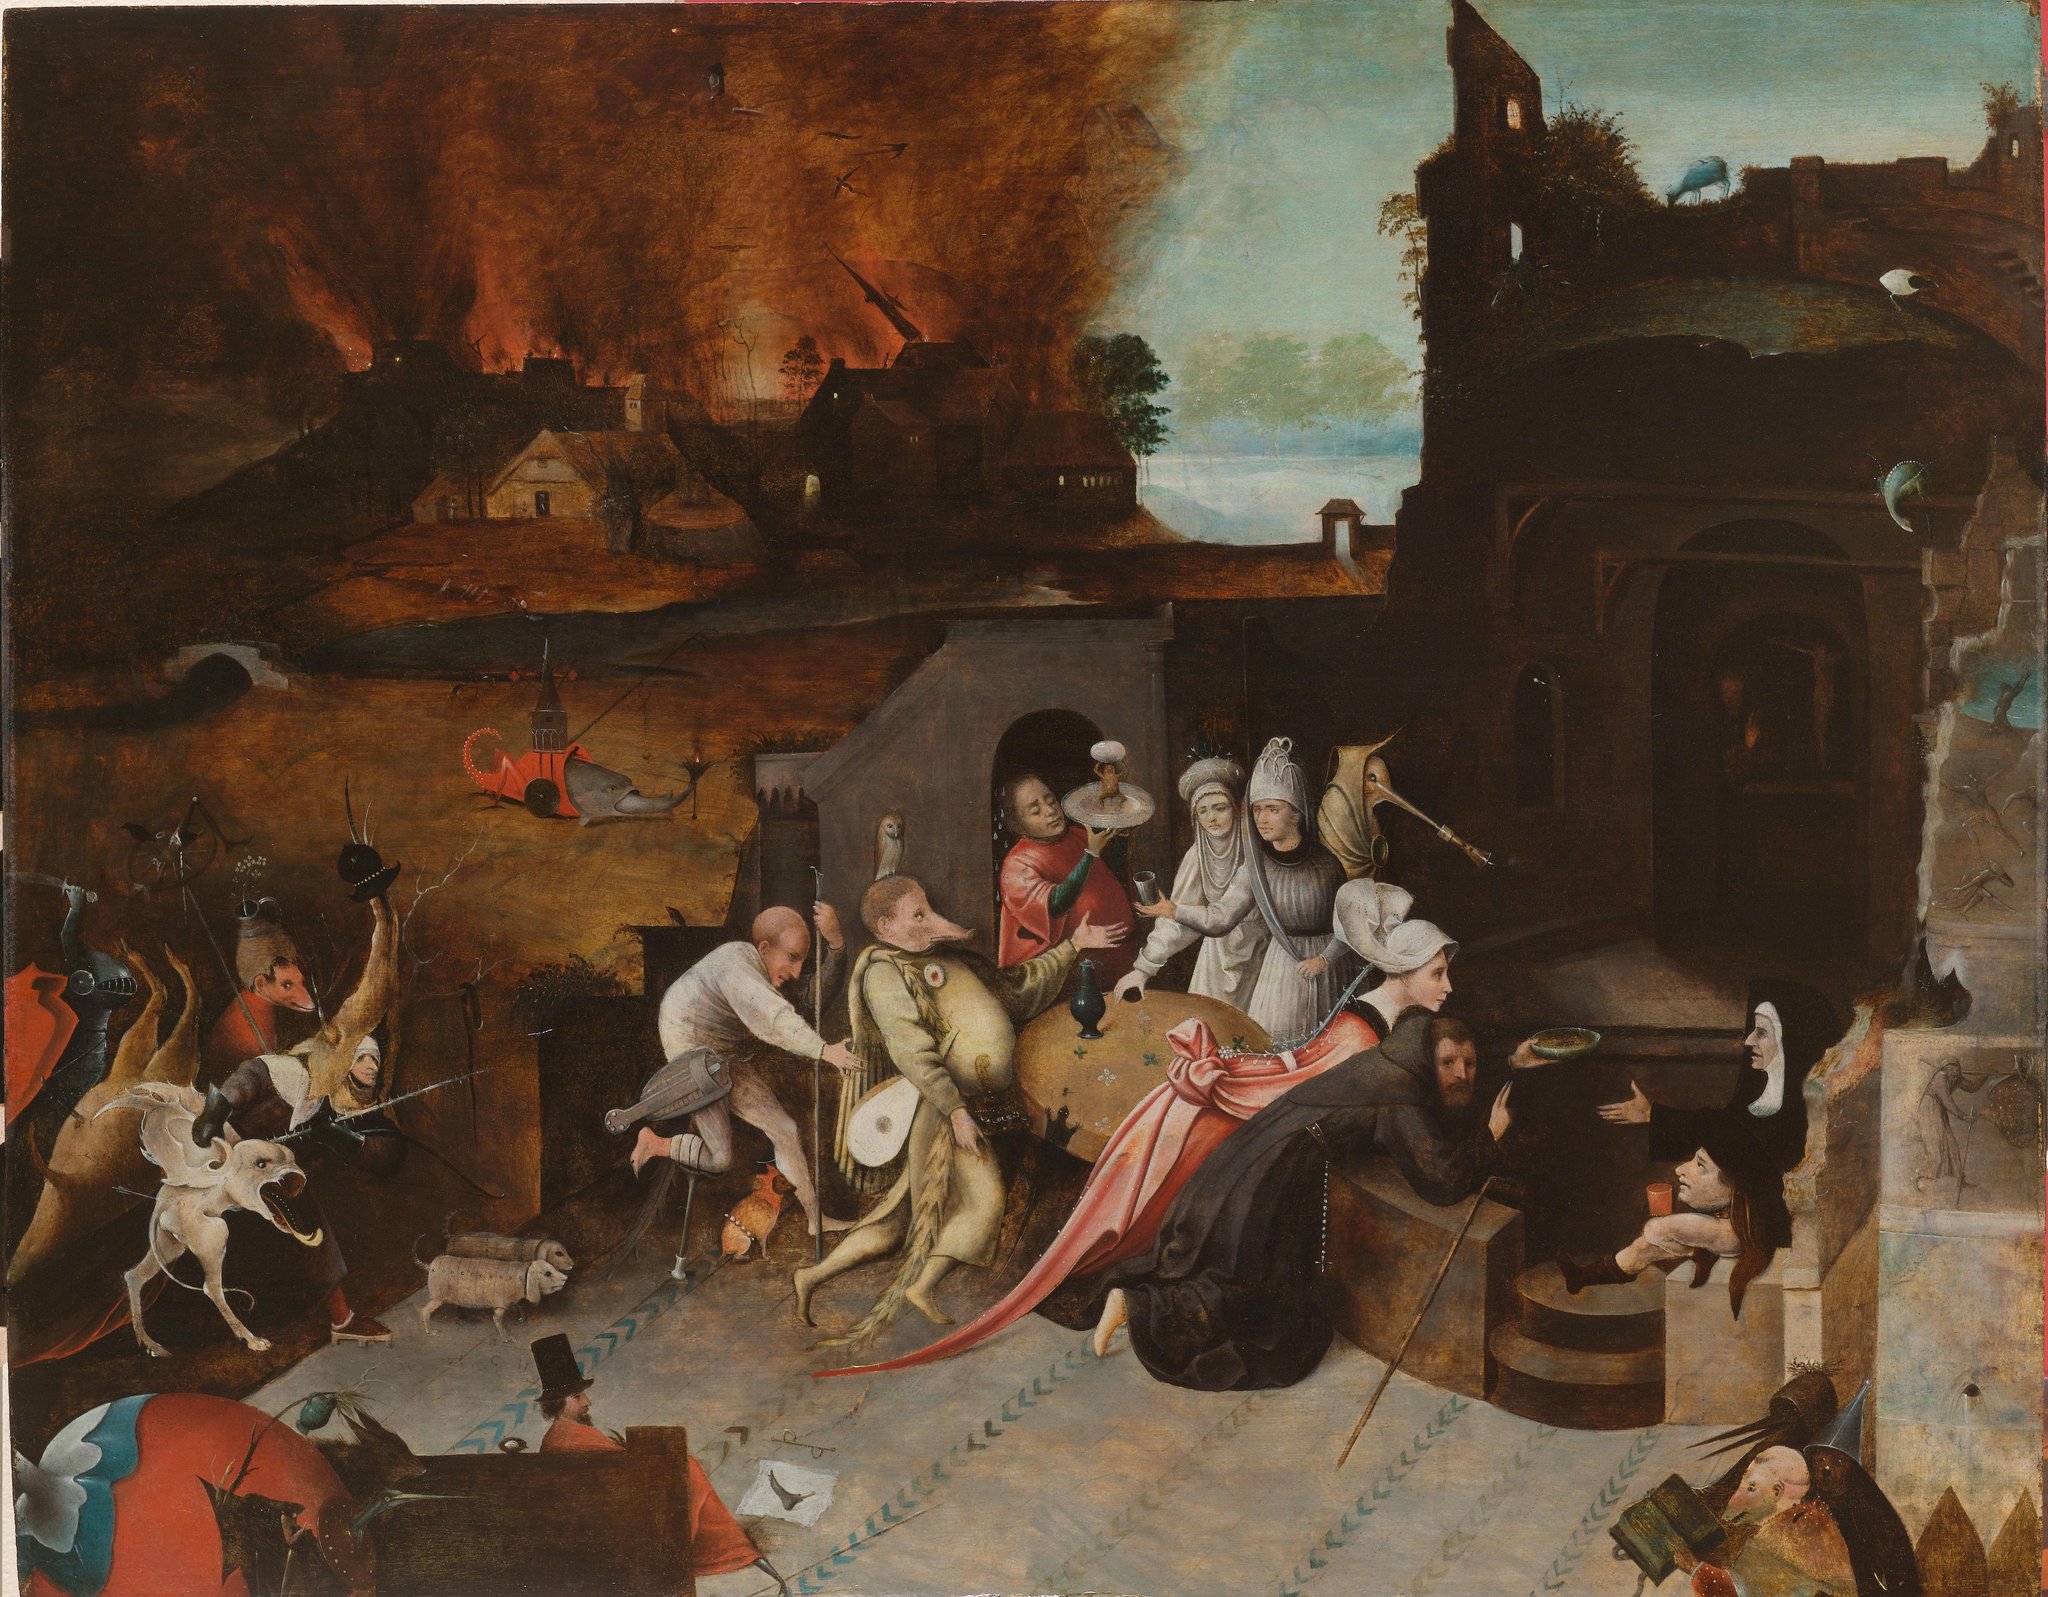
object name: painting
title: The Temptation of St Anthony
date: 1530-1600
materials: oil, panel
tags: st. antony abbot tormented by devils, attacking him on the ground or carrying him aloft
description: Verzoeking van de heilige Antonius. De knielend biddende kluizenaar wordt bezocht door een verleidelijke vrouw en allerlei gedrochten. Op de achtergrond een brandende stad. Middendeel van een drieluik.